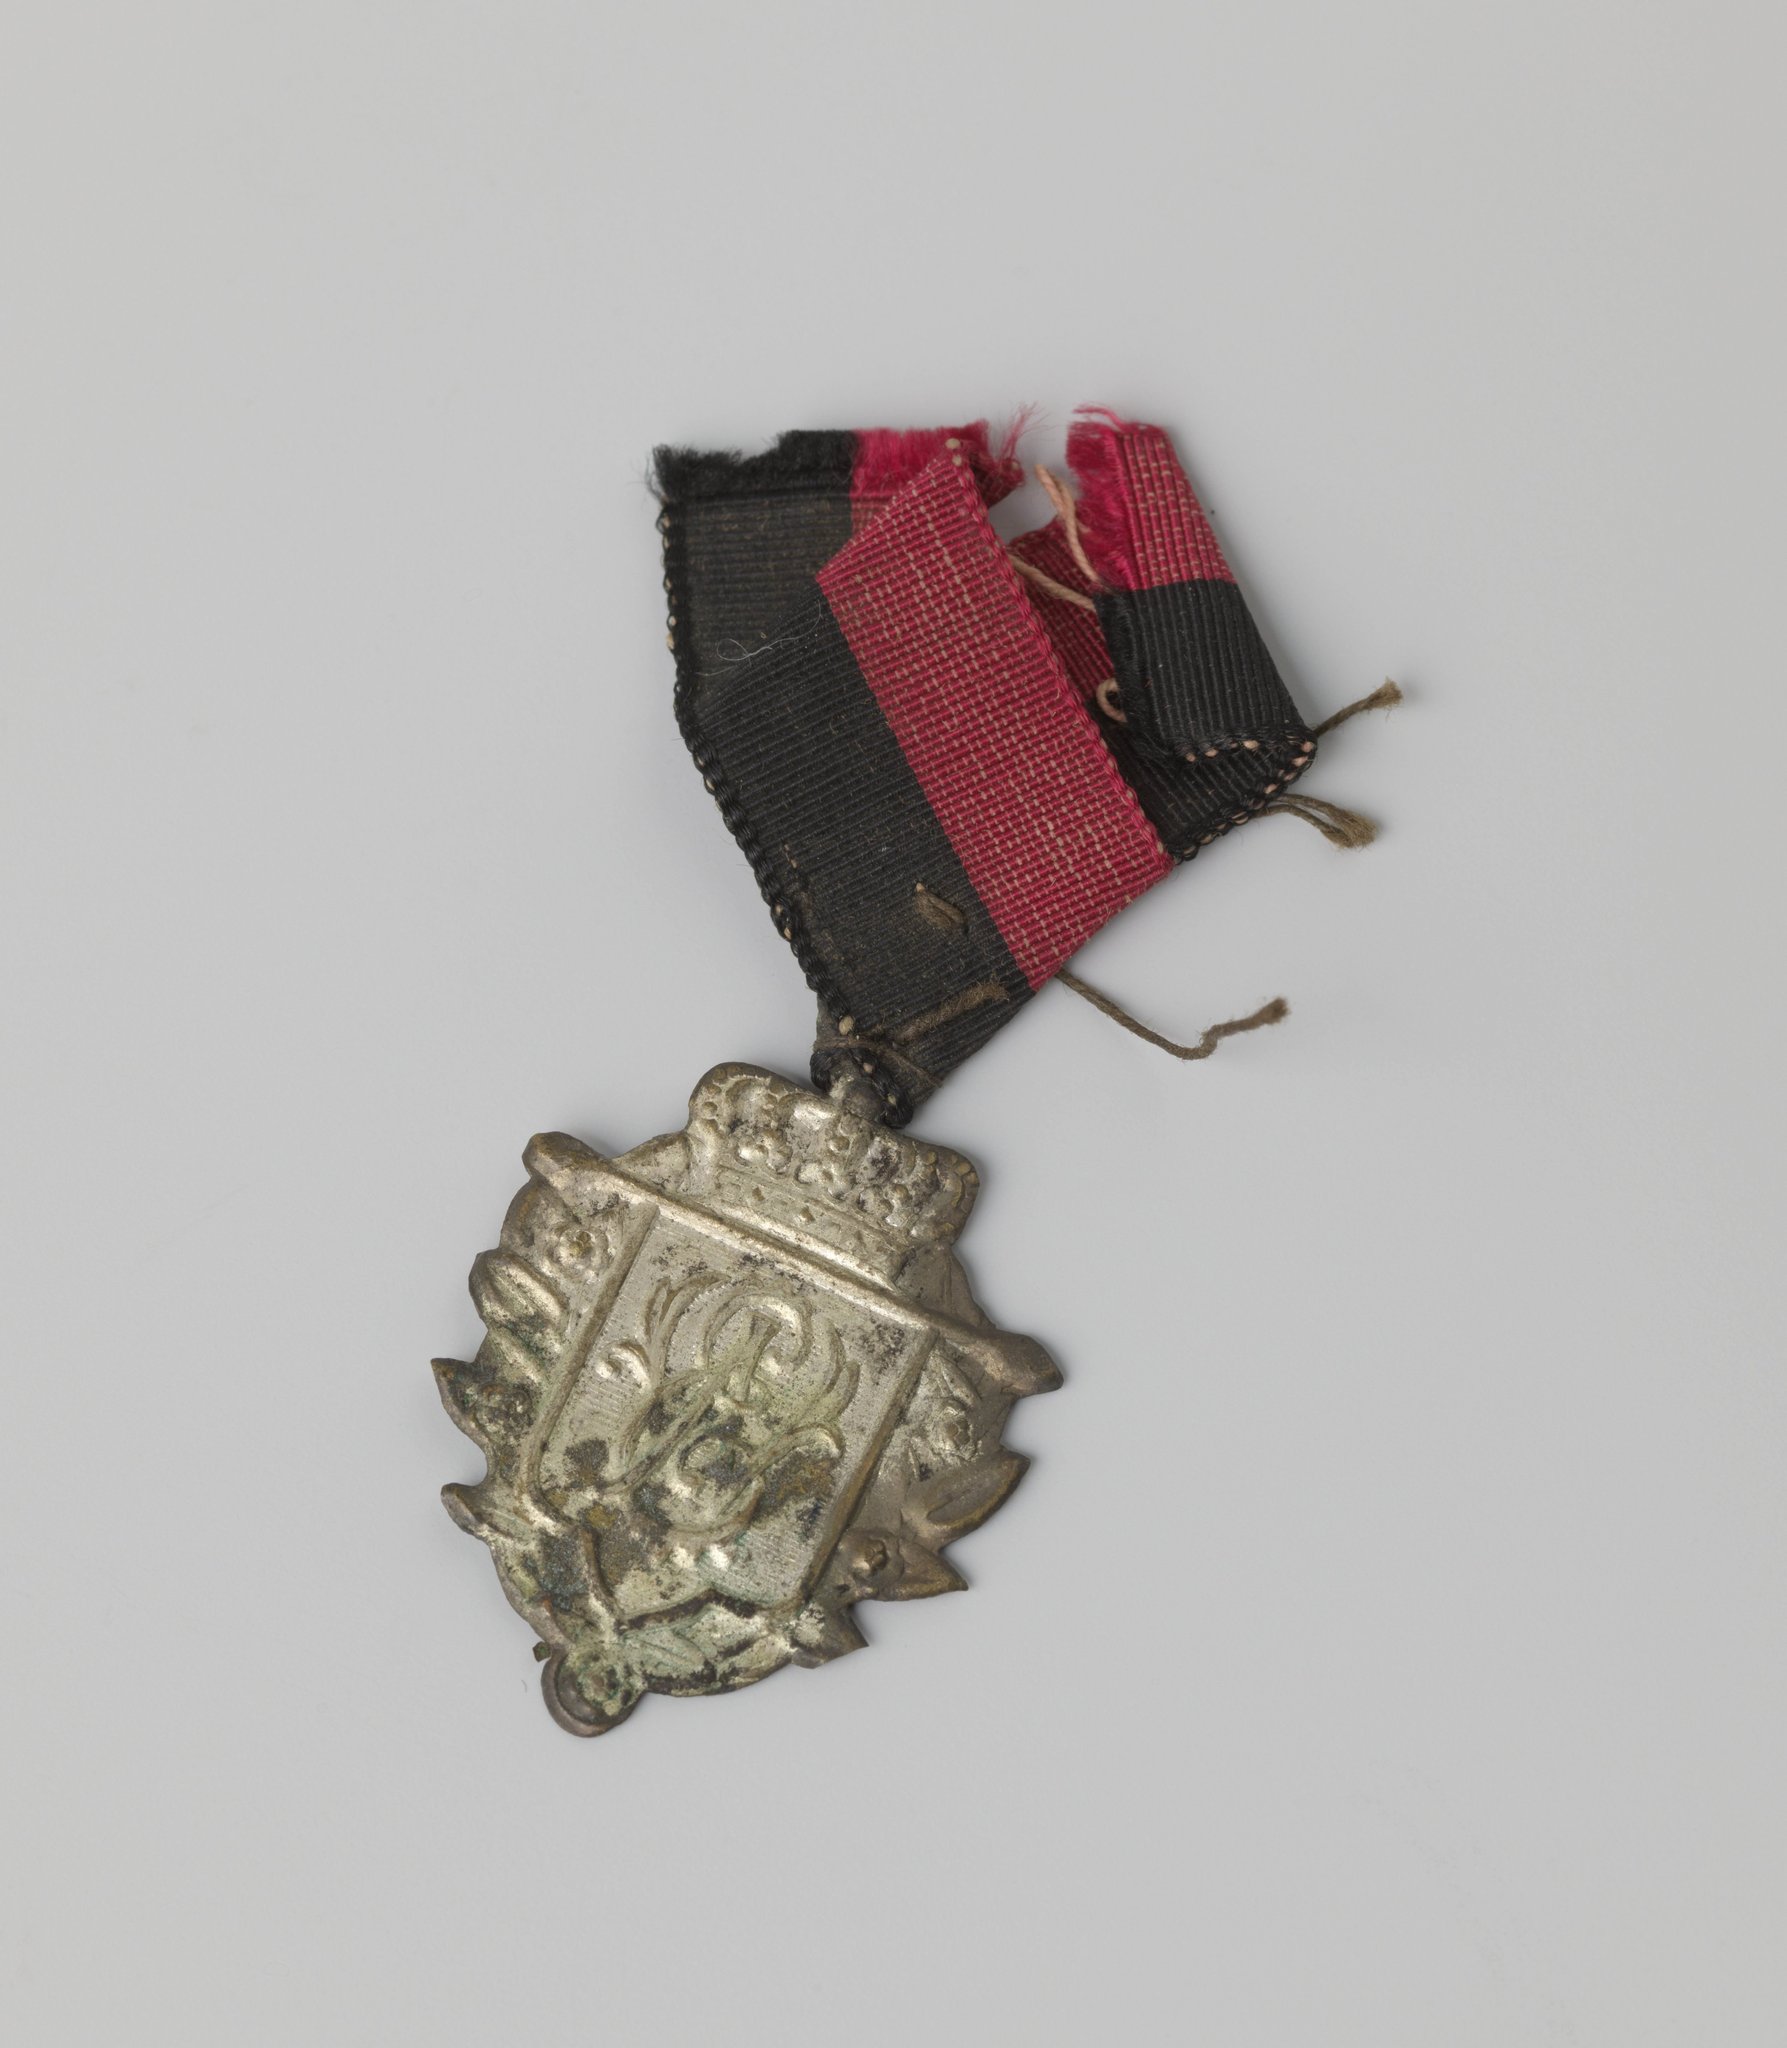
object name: insignia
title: Koperen draagteken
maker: Anonymous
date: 1832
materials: copper, silk, metal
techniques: stitching, striking, weave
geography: netherlands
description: Zeer dun, geslagen koperen decoratie in de vorm van een gekroond wapenschild omgeven door een krans, bevestigd aan een rood-zwart lintje. Gemerkt.